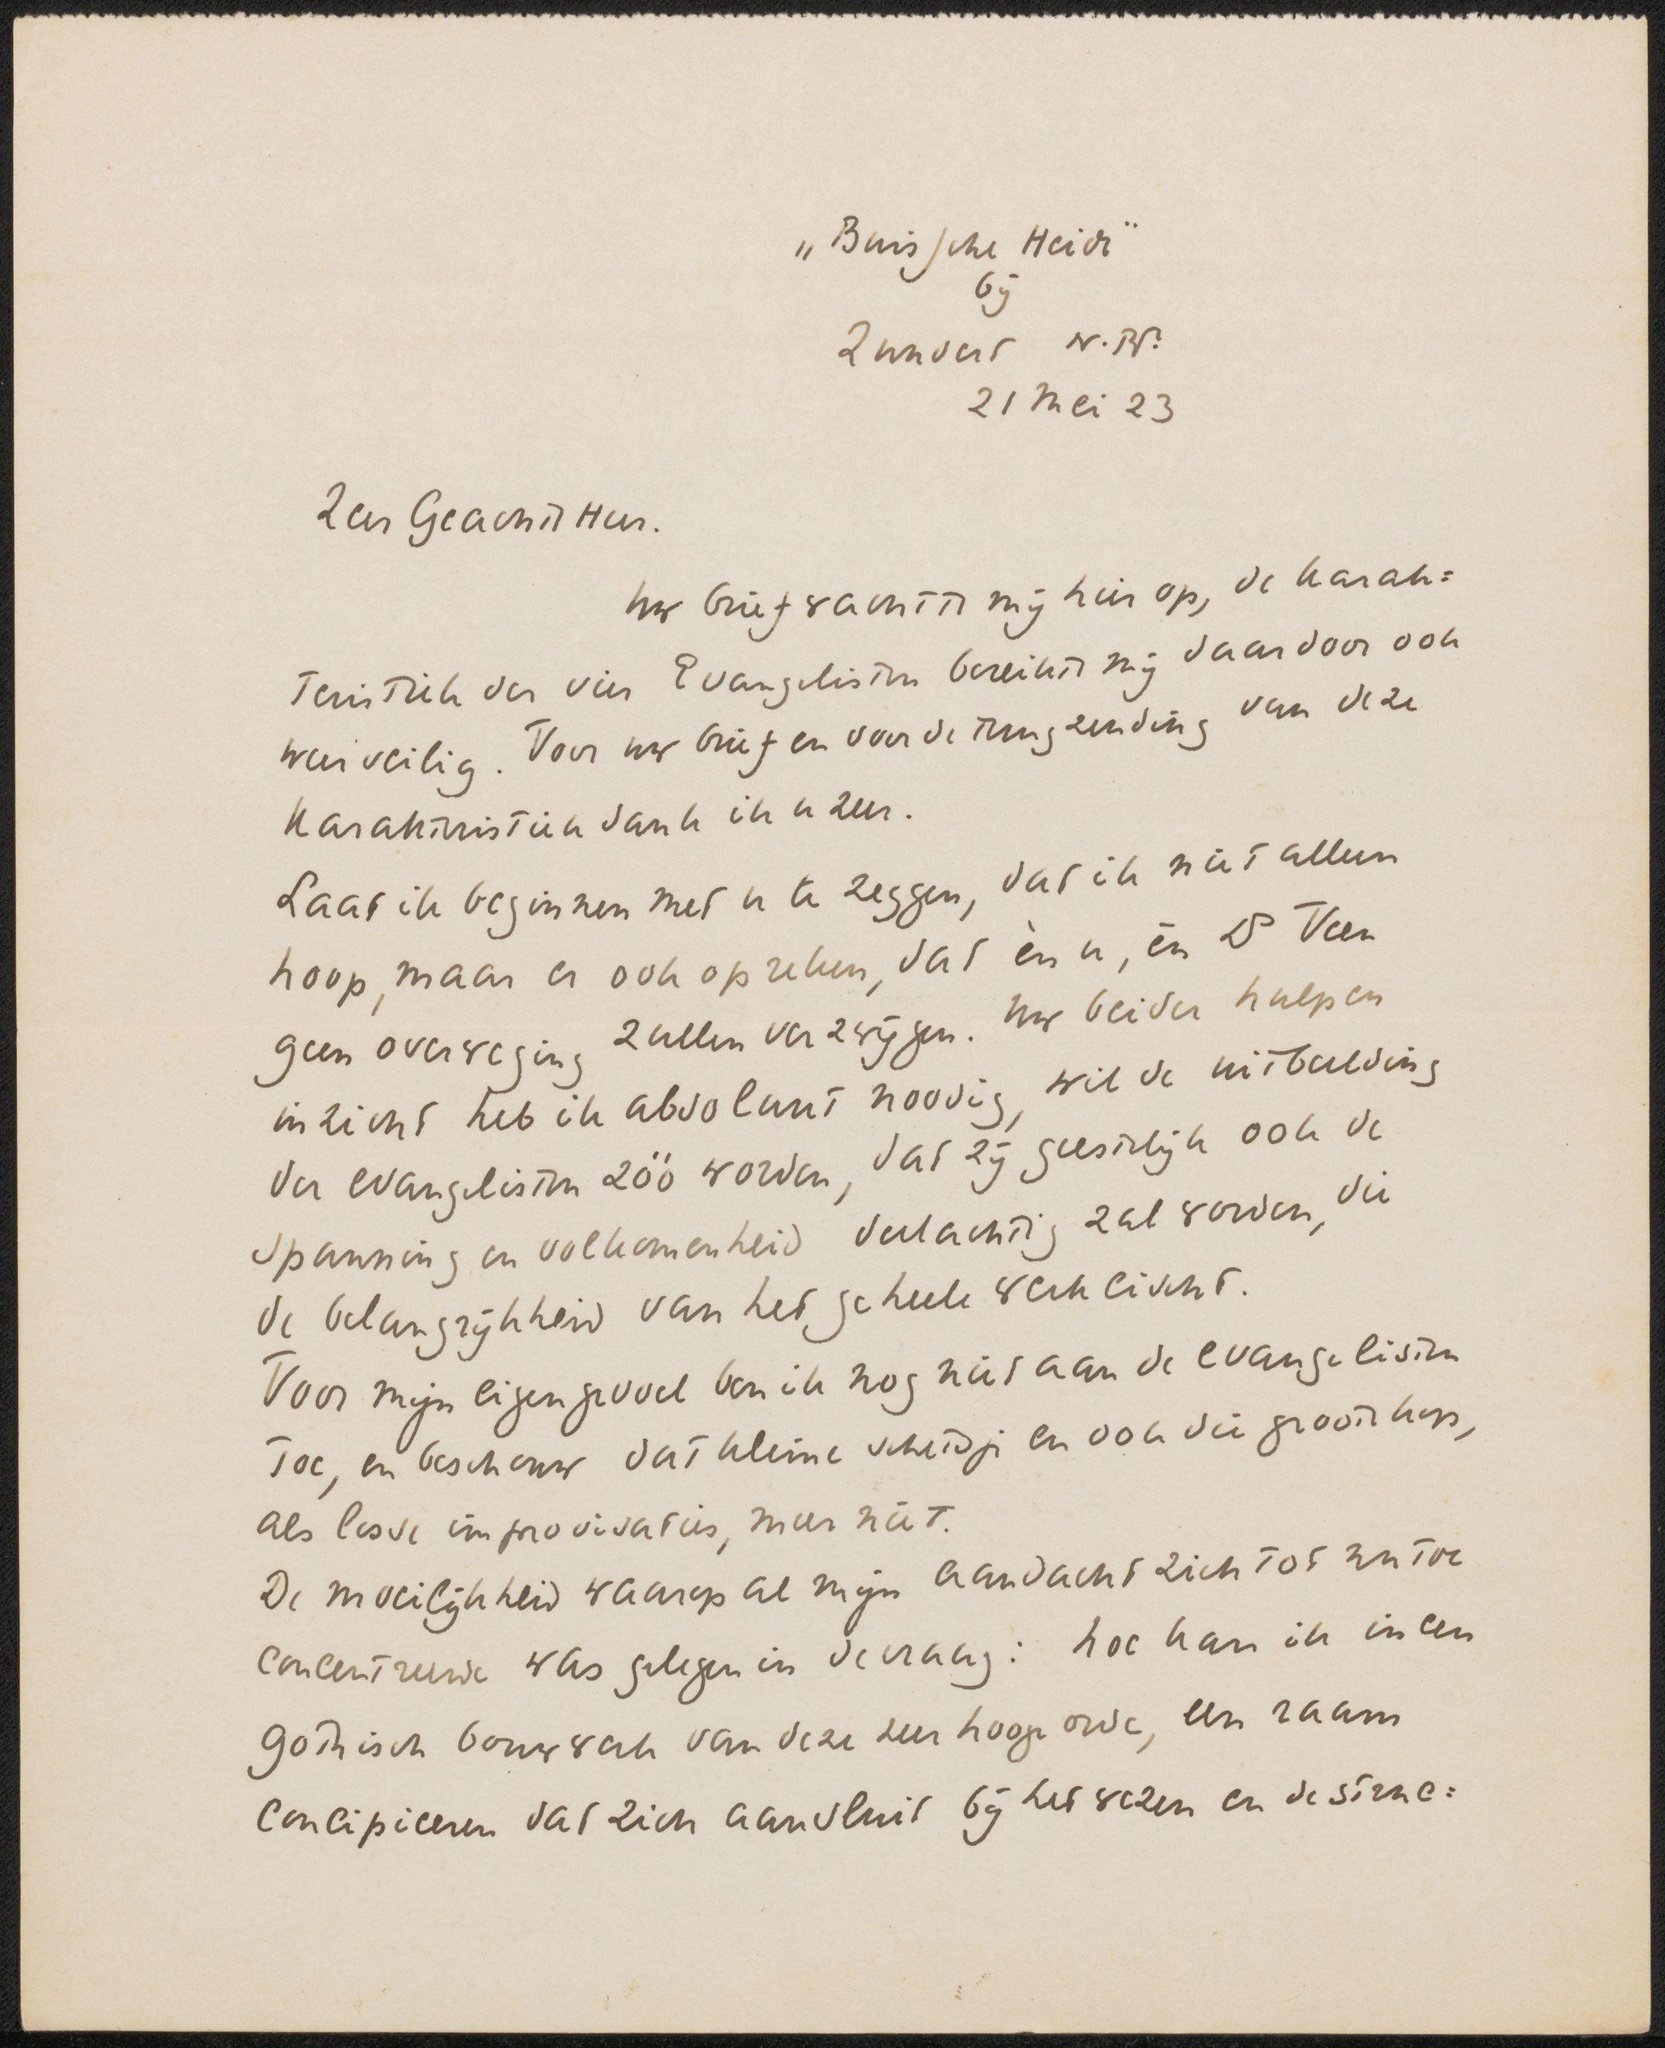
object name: letter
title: Brief aan Anneus Marinus Brouwer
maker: richard nicolaüs roland holst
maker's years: 1868-1938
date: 1923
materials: ink, paper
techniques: pen, writing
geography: zundert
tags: dutch east indies, the, zeist, willem bogtman, drawing, applied arts, arts and crafts; industrial design, architecture, workshop, studio of the artist (in general), christian religion, utrecht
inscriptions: collector's mark: ‘RPK’